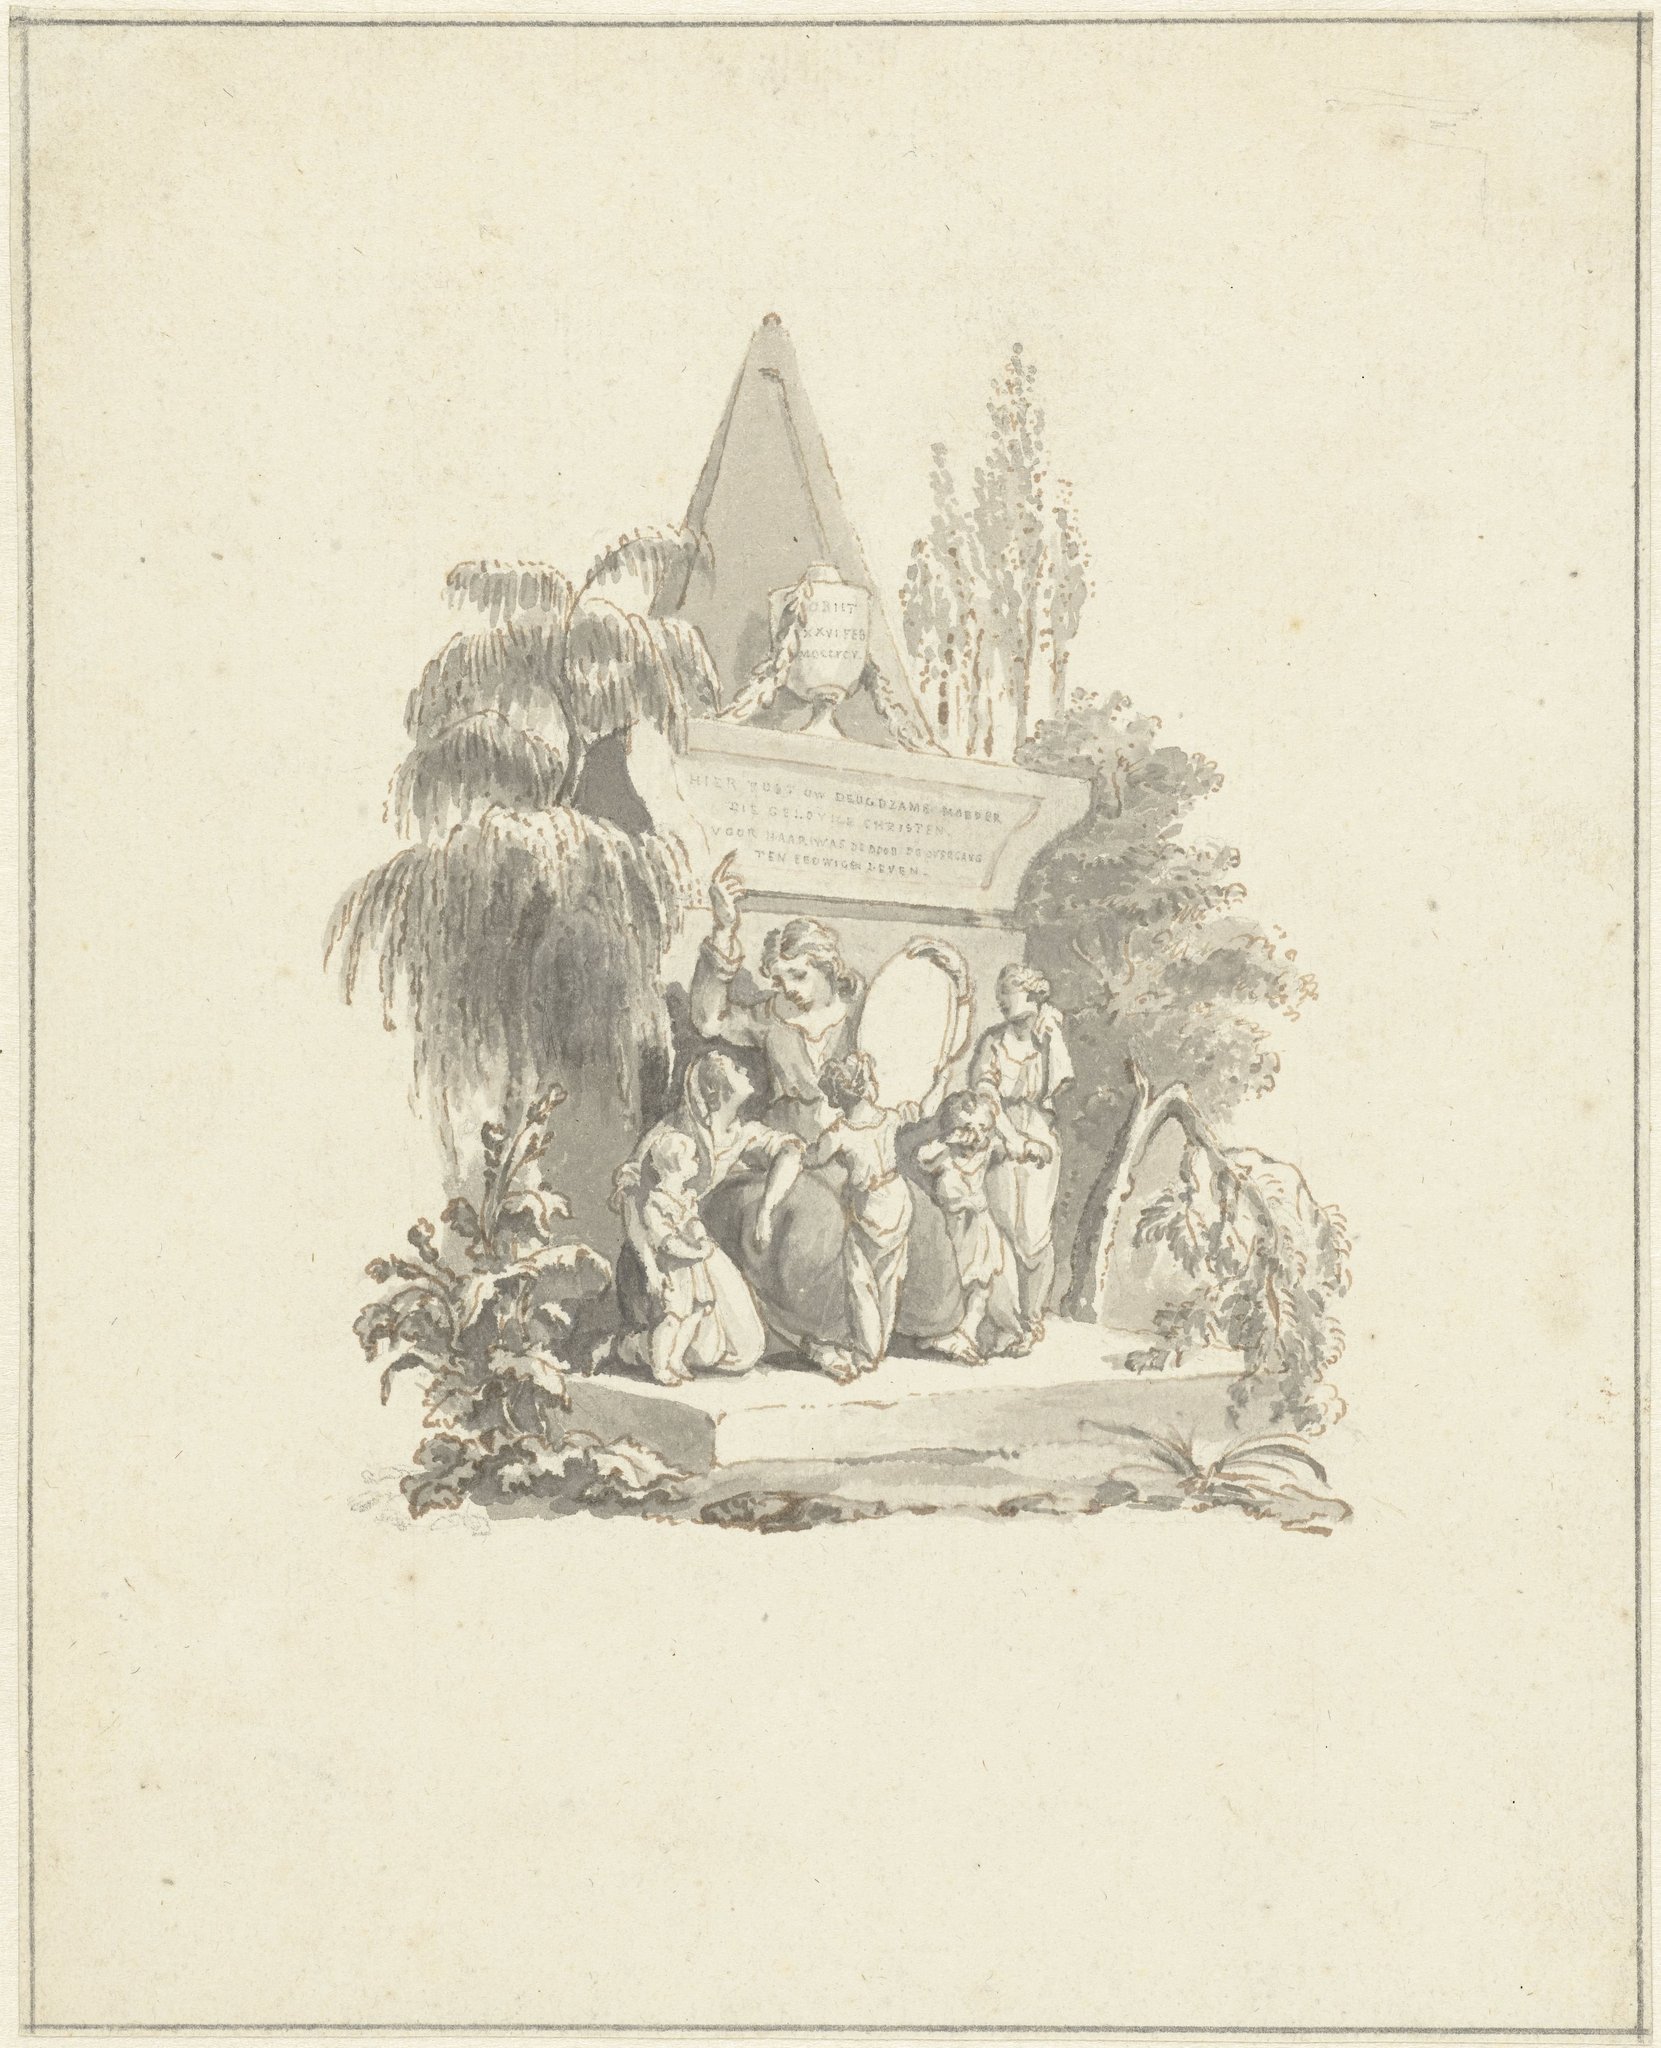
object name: drawing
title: Grafmonument voor een overleden vrouw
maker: reinier vinkeles (i)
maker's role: draughtsman, print maker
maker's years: 1741-1816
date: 1795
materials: ink, paper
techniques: brush, pen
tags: pyramid (marking grave), grave-building, monumental tomb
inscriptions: inscription: ‘Obiit XXV FEB MDCCCXCV / Hier rust uw deugdzame moeder / die gelovige christen / voor haar was de dood de overgang / ten eeuwigen leven.’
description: Grafmonument voor een overleden vrouw: piramide met sarcofaag en man met vijf kinderen.